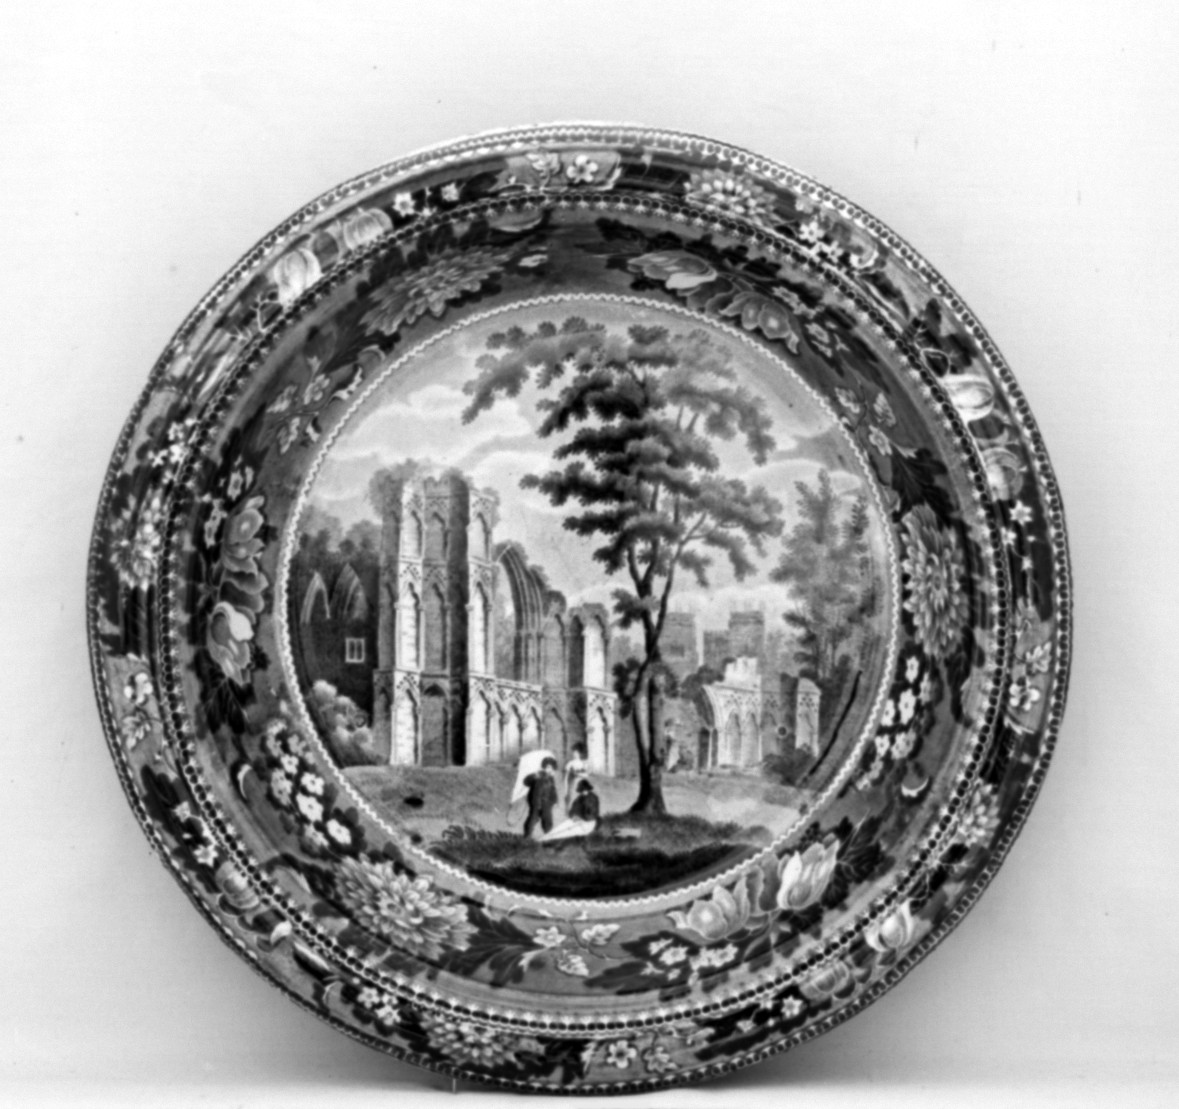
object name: basin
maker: william adams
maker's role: maker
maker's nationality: british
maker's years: 1798-1865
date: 1801-1900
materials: pottery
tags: buildings,boys,flowers,trees